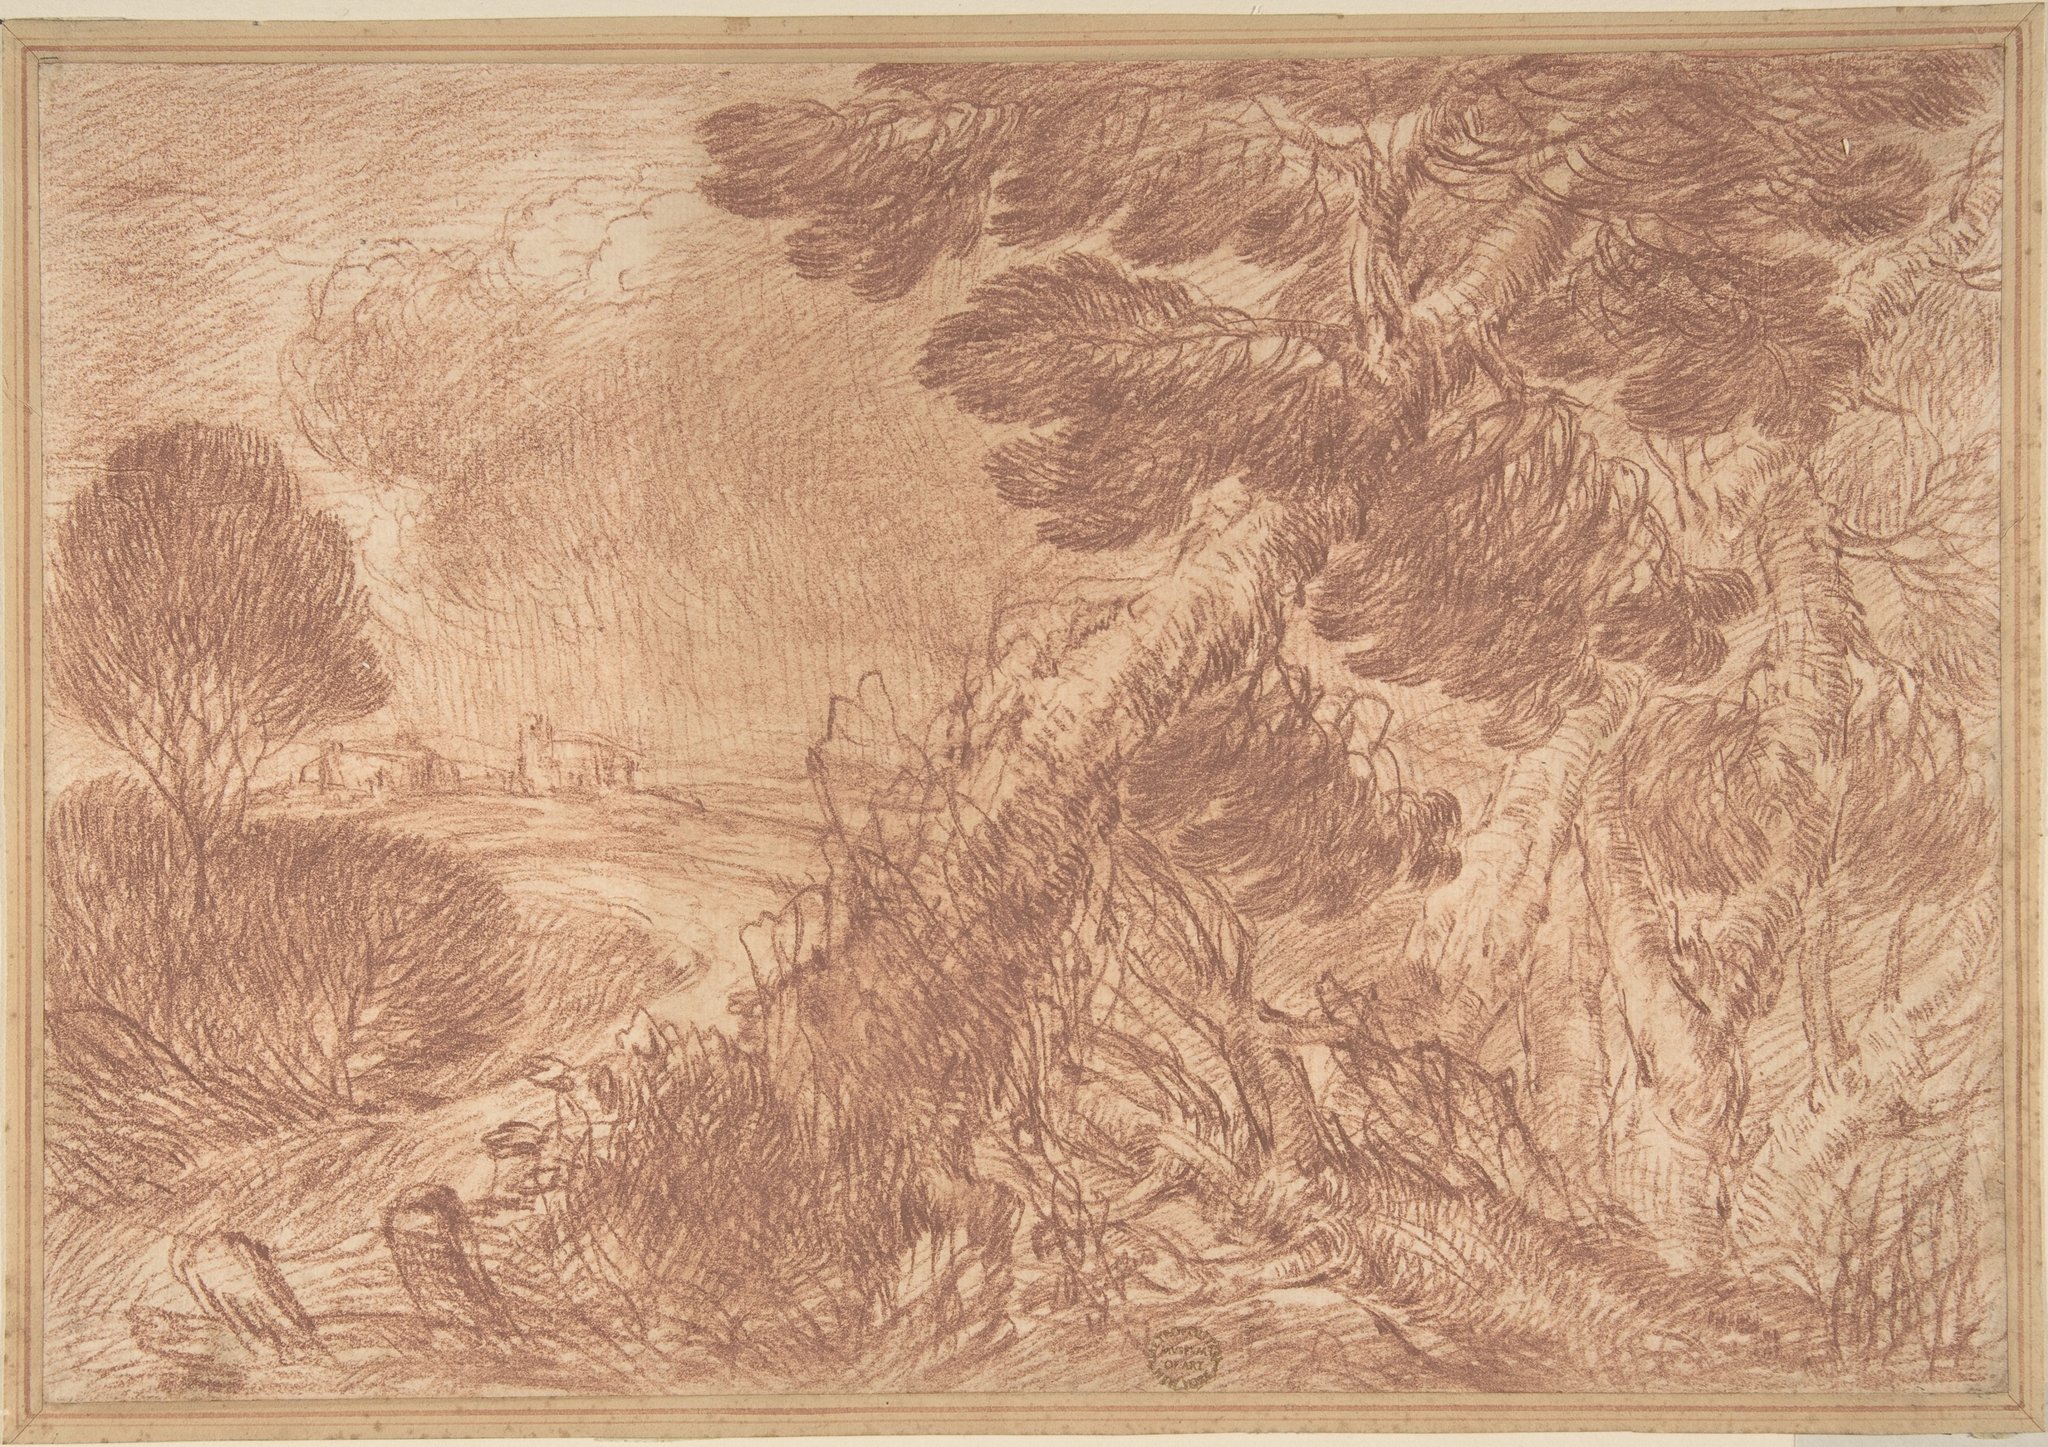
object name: drawing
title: Landscape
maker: anonymous, italian, 18th century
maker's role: artist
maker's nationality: italian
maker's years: 1700-1800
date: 1701-1800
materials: chalk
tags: landscapes,trees